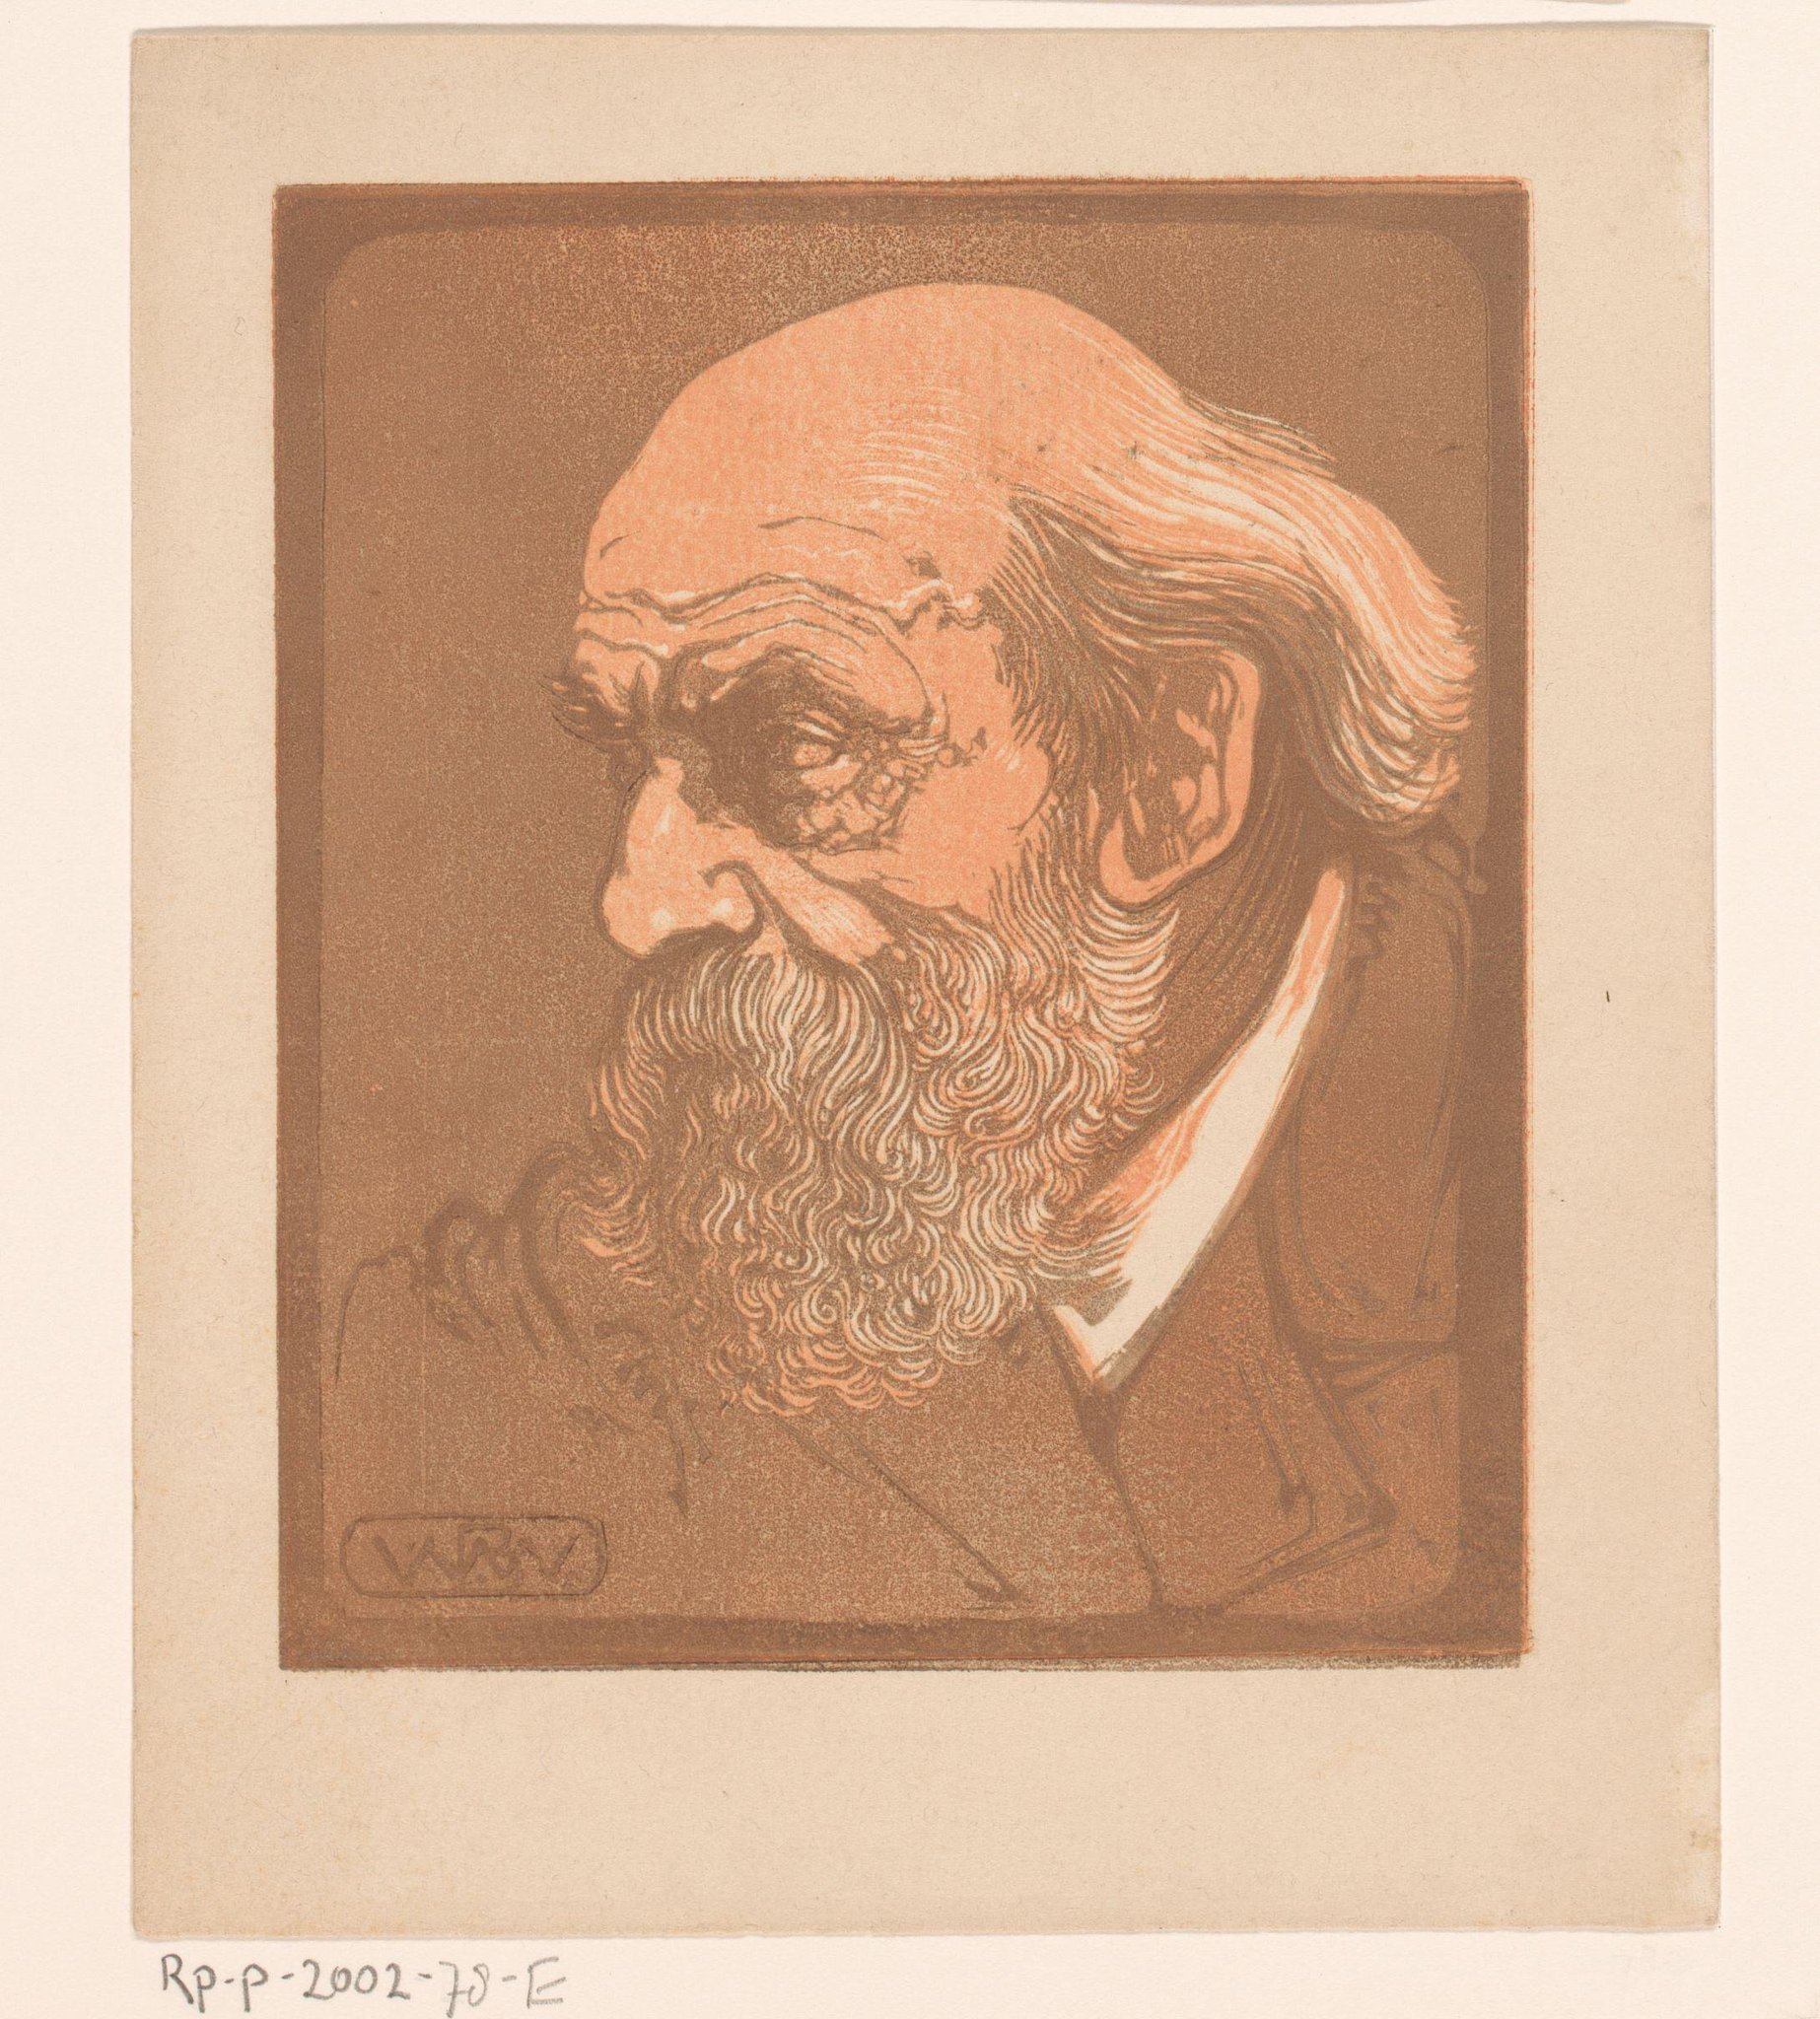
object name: print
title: Portret van Pierre Cuypers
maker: bernard willem wierink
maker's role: draughtsman, print maker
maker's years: 1856-1939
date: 1918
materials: paper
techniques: relief print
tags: draughtsman, pierre joseph hubert cuypers, portrait, self-portrait of architect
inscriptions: collector's mark: Lugt 2228, collector's mark: Lugt 2760, collector's mark: ‘Bh’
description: Deze prent is vermoedelijk een plaatsnede, ook al wordt in de literatuur veelal gesproken over een houtsnede. Voor zover Wierink zijn prenten in hoogdruk zelf nader heeft omschreven, heeft hij altijd de term 'plaatsnede' gebruikt.